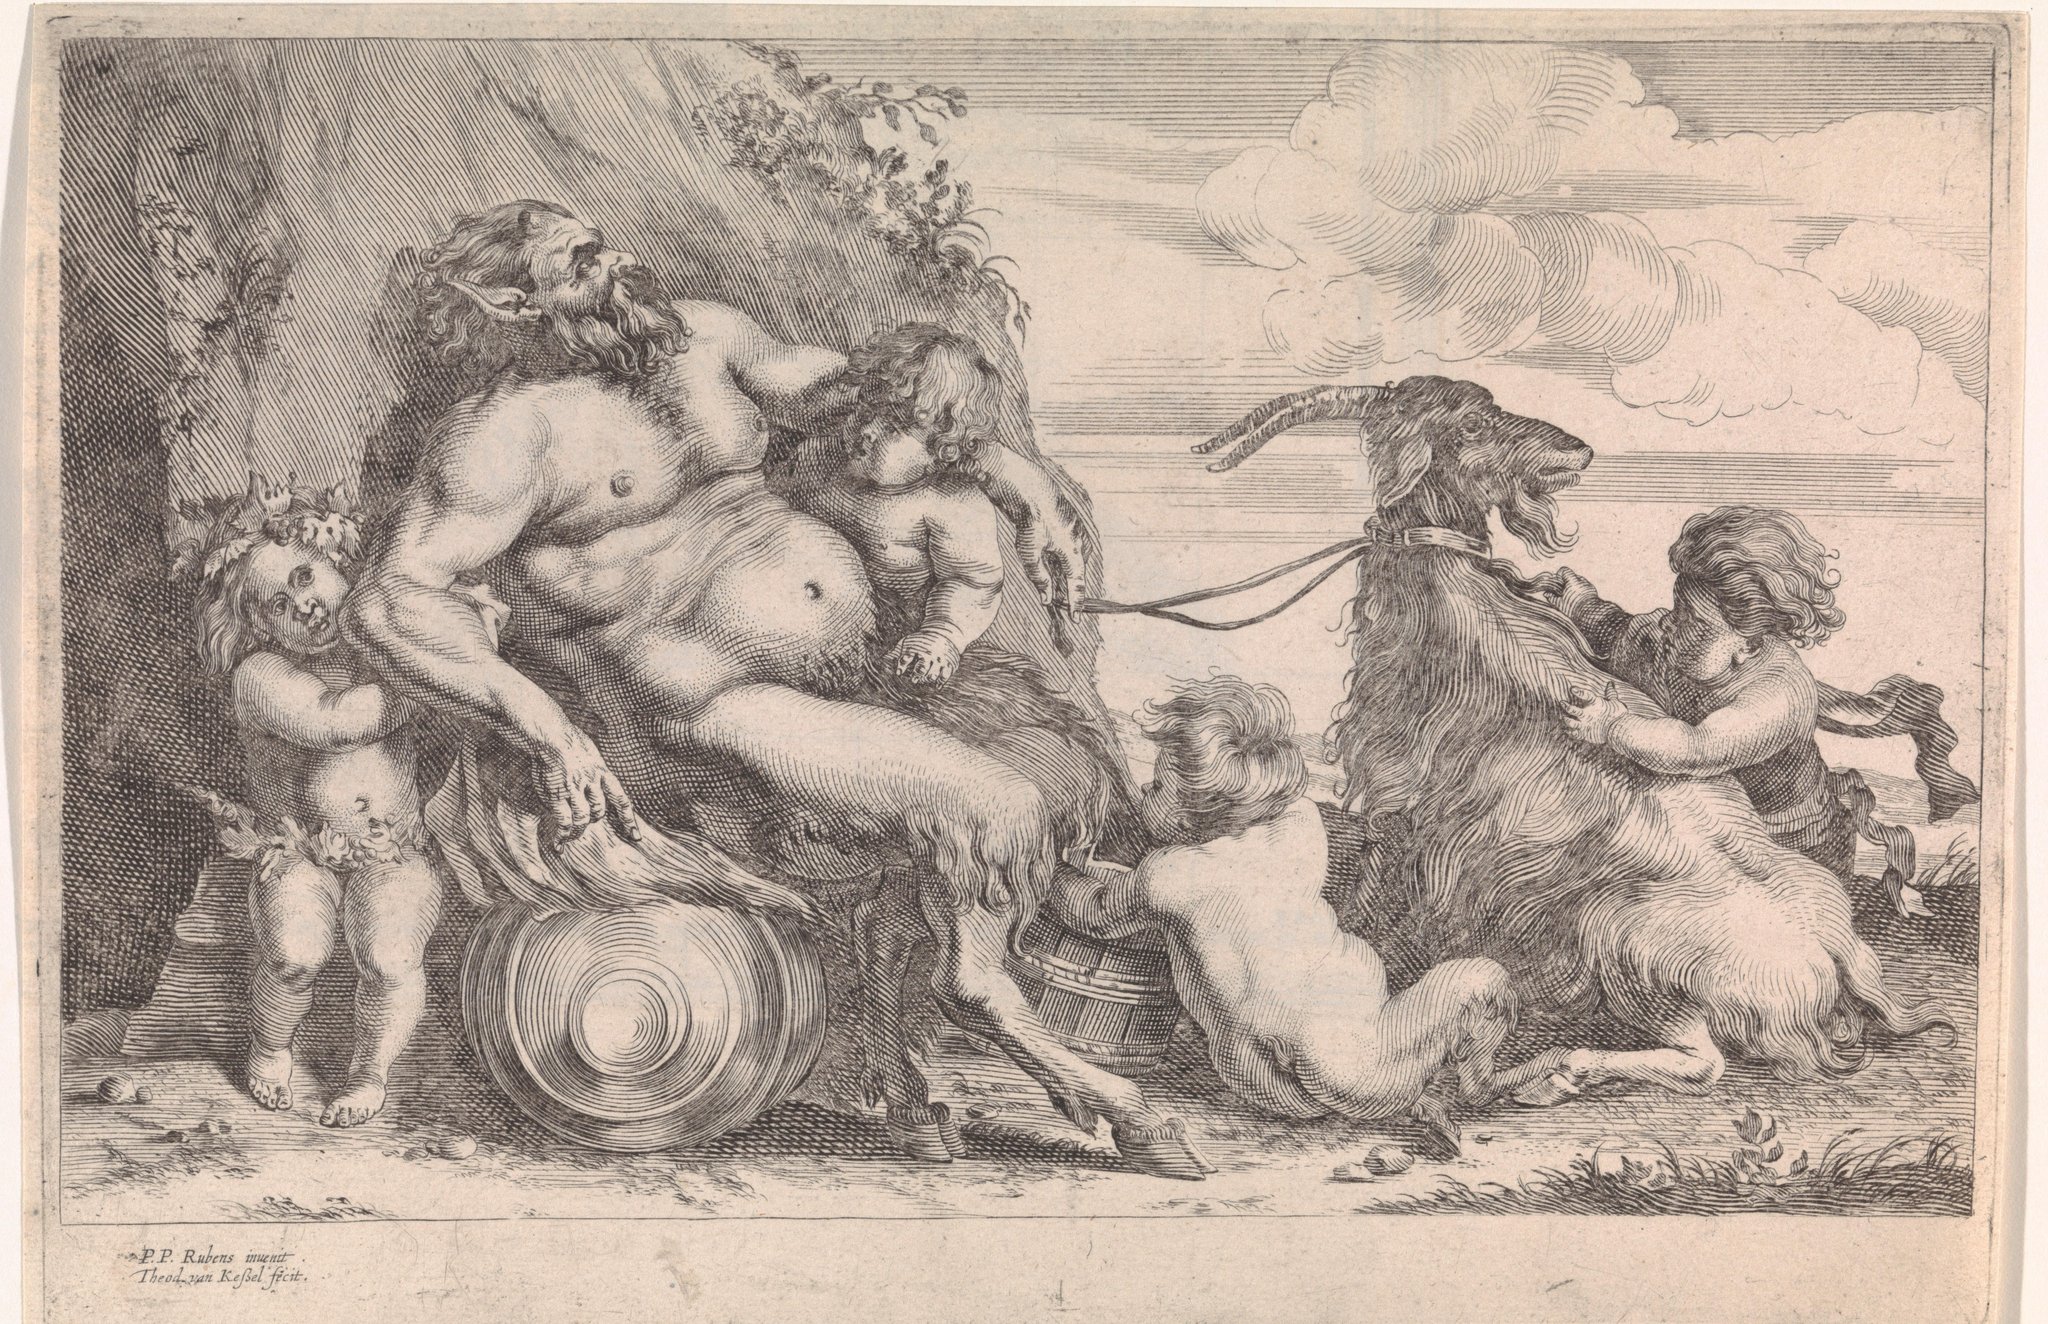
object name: print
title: Mythologische figuren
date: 1630-1660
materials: paper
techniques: engraving, etching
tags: attributes of pan, (story of) pan, cupids: 'amores', 'amoretti', 'putti'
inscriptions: collector's mark: Lugt 2228, collector's mark: Lugt 581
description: Pan zit op een ton tegen een rots en houdt het leidsel van een geit nonchalant in zijn linkerhand. Hij wordt gezelschap gehouden door de jonge Syrinx en drie jonge saters. Deze prent maakt deel uit van een vierdelige serie over mythologische figuren. Op de verso zijde een stuk van een landkaart.